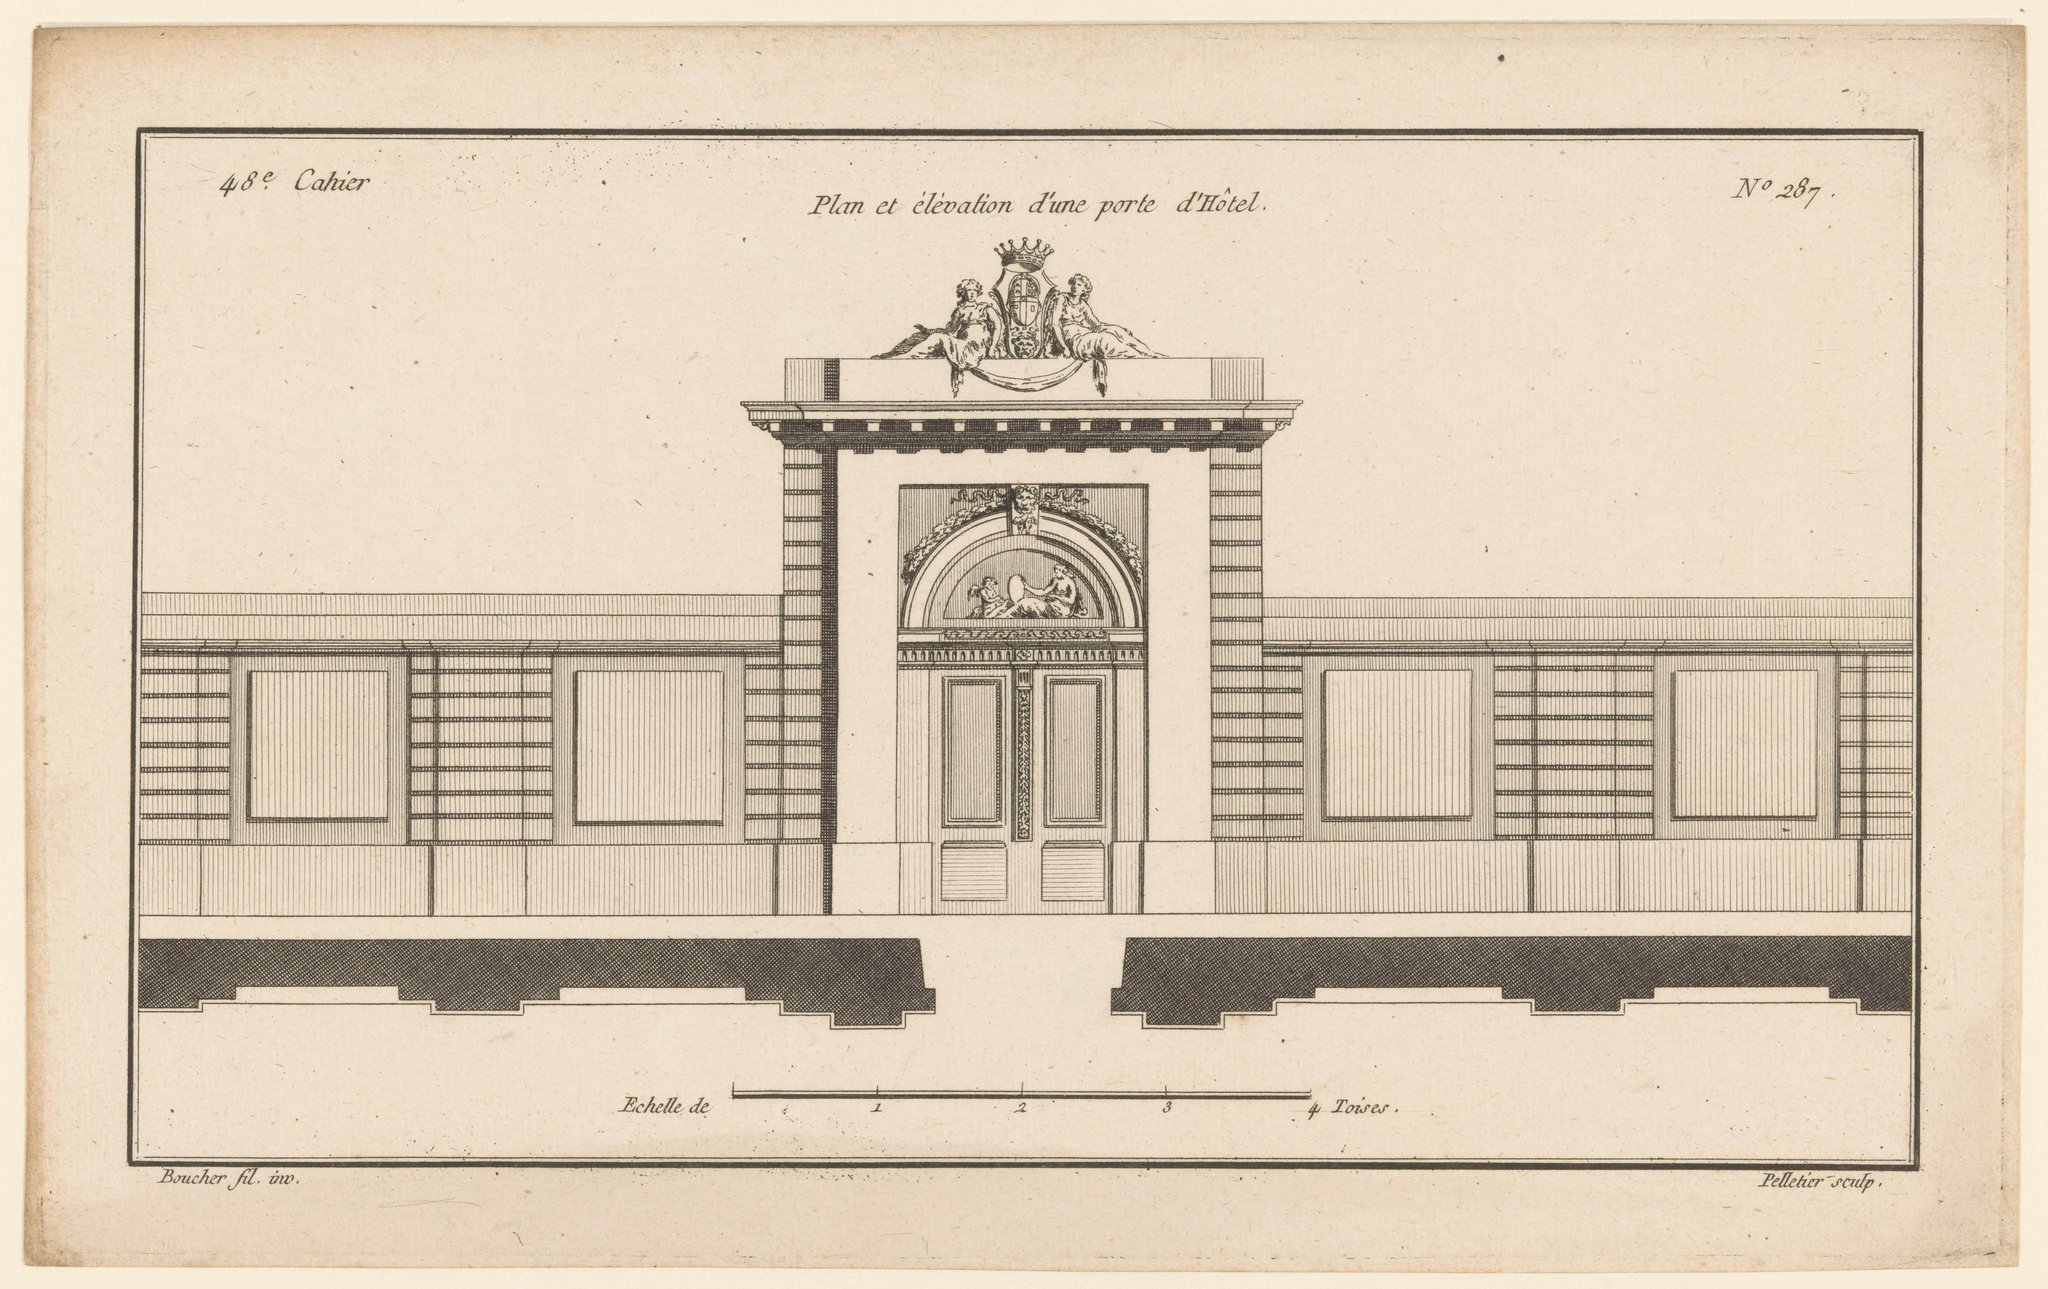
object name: print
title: Hotelpoorten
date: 1772-1779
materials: paper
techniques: engraving, etching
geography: paris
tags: sitting figure - aa - female human figure, gate, entrance, armorial bearing, heraldry, venus and cupid (cupid not being mere attribute)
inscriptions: collector's mark: Lugt 2228, collector's mark: Lugt 2760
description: Een hotelpoort met Venus en Cupido, daarboven een gekroond wapenschild geflankeerd door twee zittende vrouwen. Prentnummer 287.